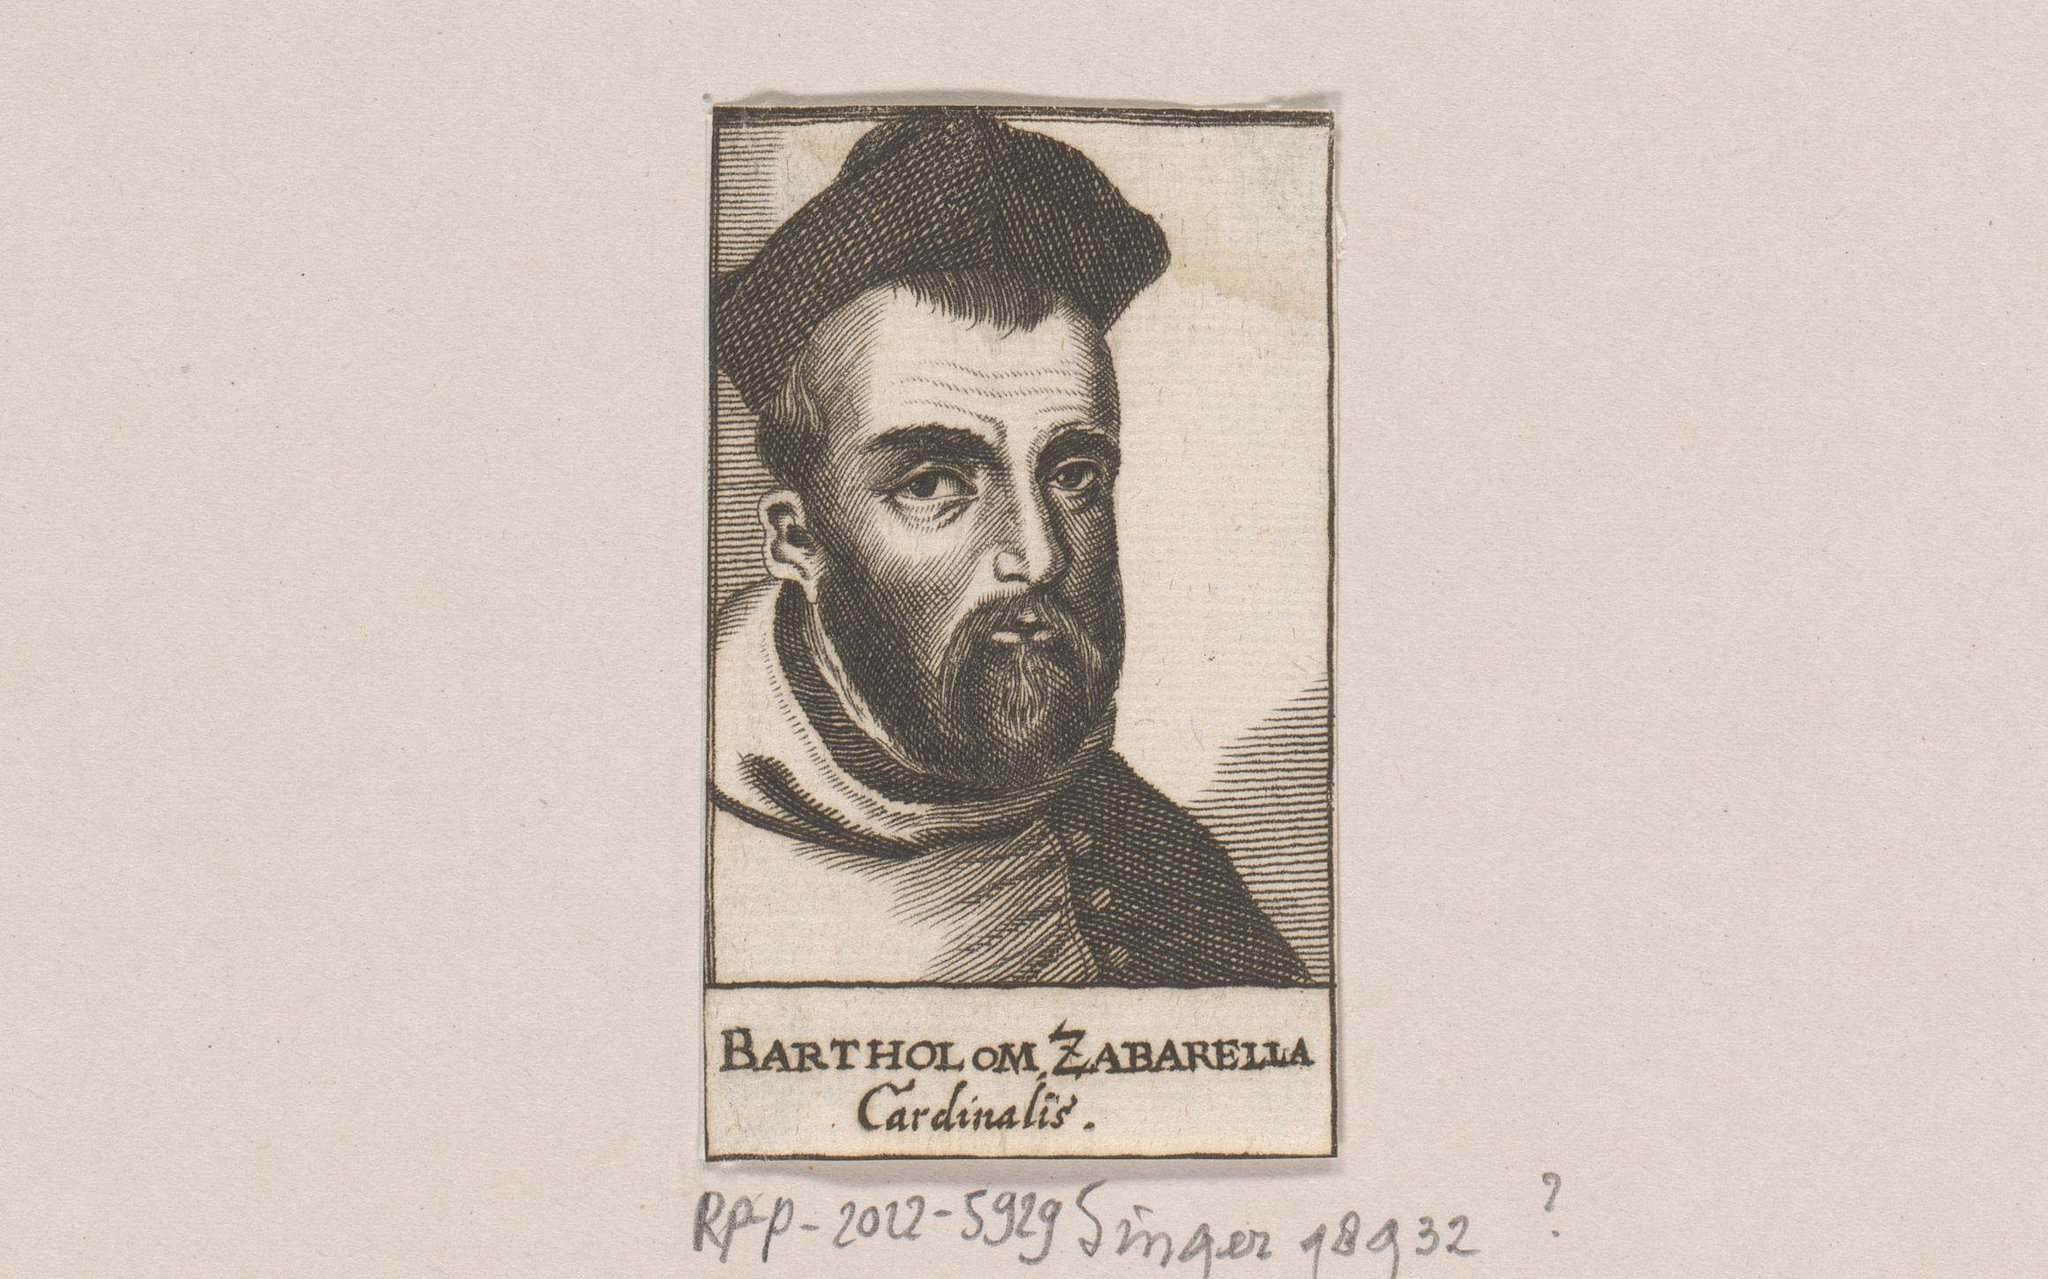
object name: print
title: Portret van Bartolomeo Zabarella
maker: Anonymous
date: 1688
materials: paper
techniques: engraving, etching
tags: archbishop, bishop, etc. (roman catholic), historical persons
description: Prent waarschijnlijk uit: Freher, Paul. Theatrum virorum eruditione clarorum. Neurenberg: Johann Hoffmann, 1688, dl. 1.